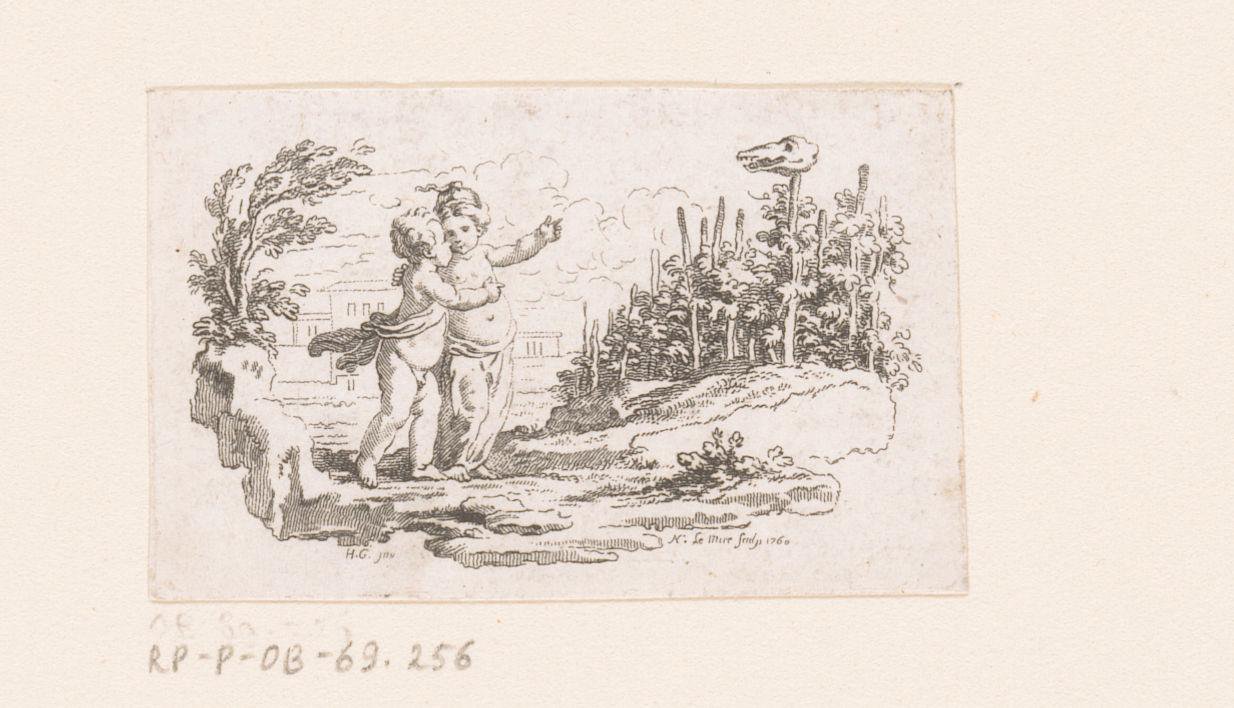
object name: print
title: Vignet met naakte jongen en meisje die naar een dierenschedel op een stok wijst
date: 1760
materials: paper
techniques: etching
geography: france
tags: boy (child between toddler and youth), skull as danger signal, girl (child between toddler and youth)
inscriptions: date